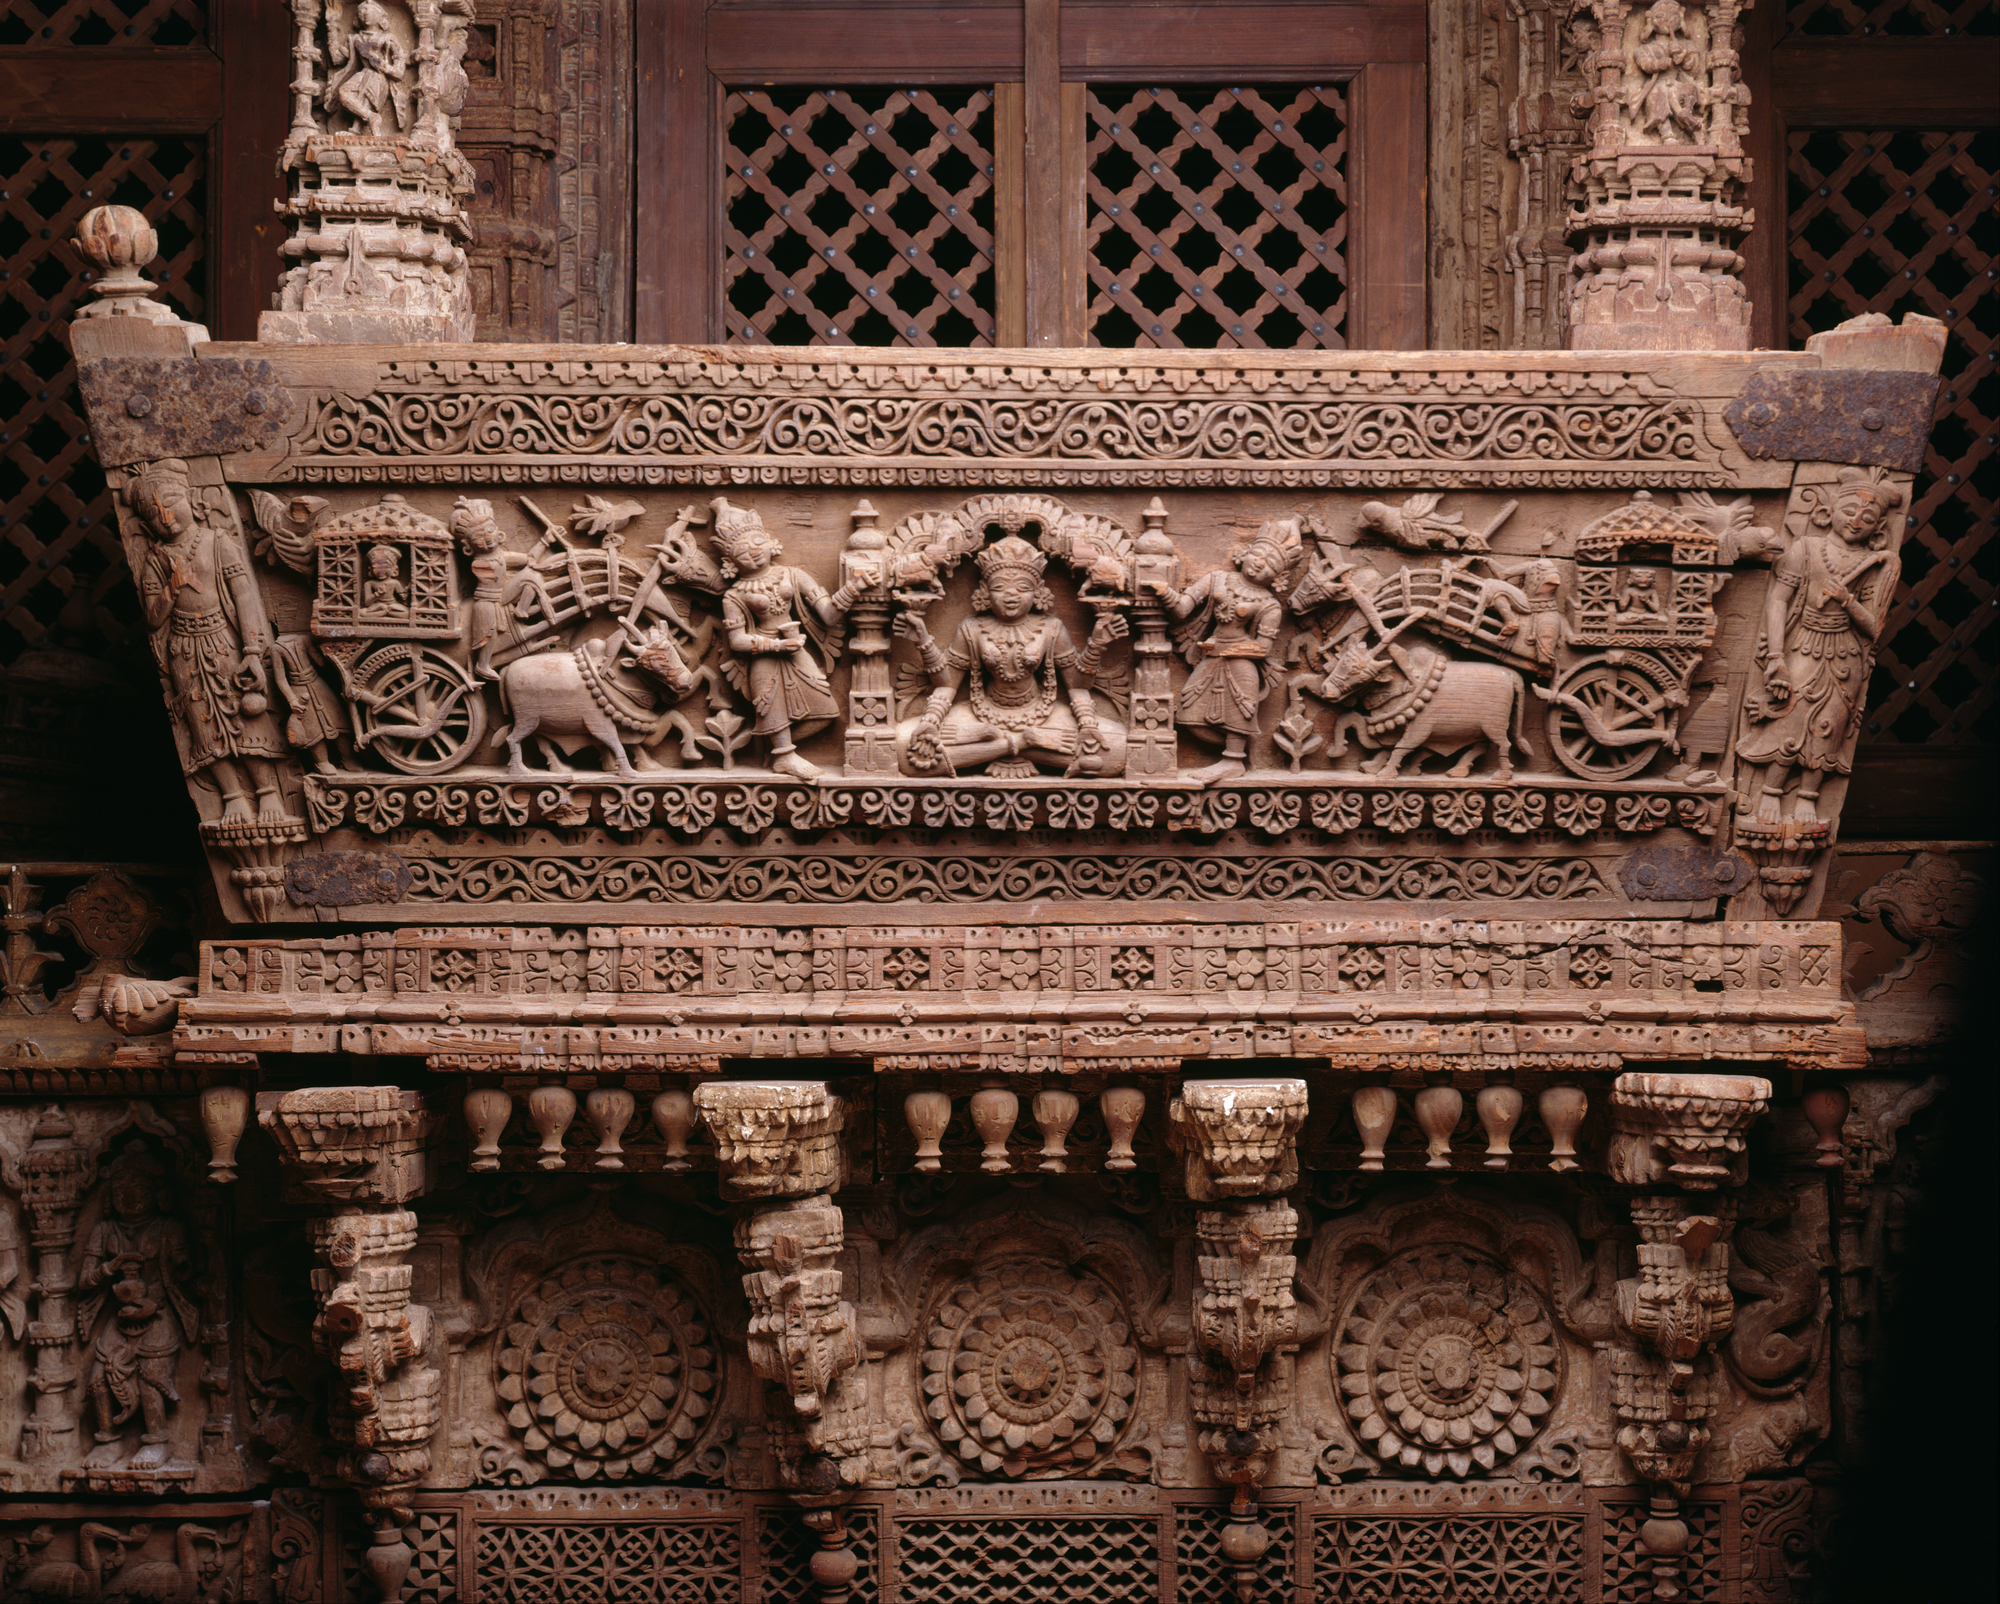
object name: architectural ensemble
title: Architectural Ensemble from a Jain Meeting Hall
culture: indian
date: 1576-1600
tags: human figures,animals,carriages